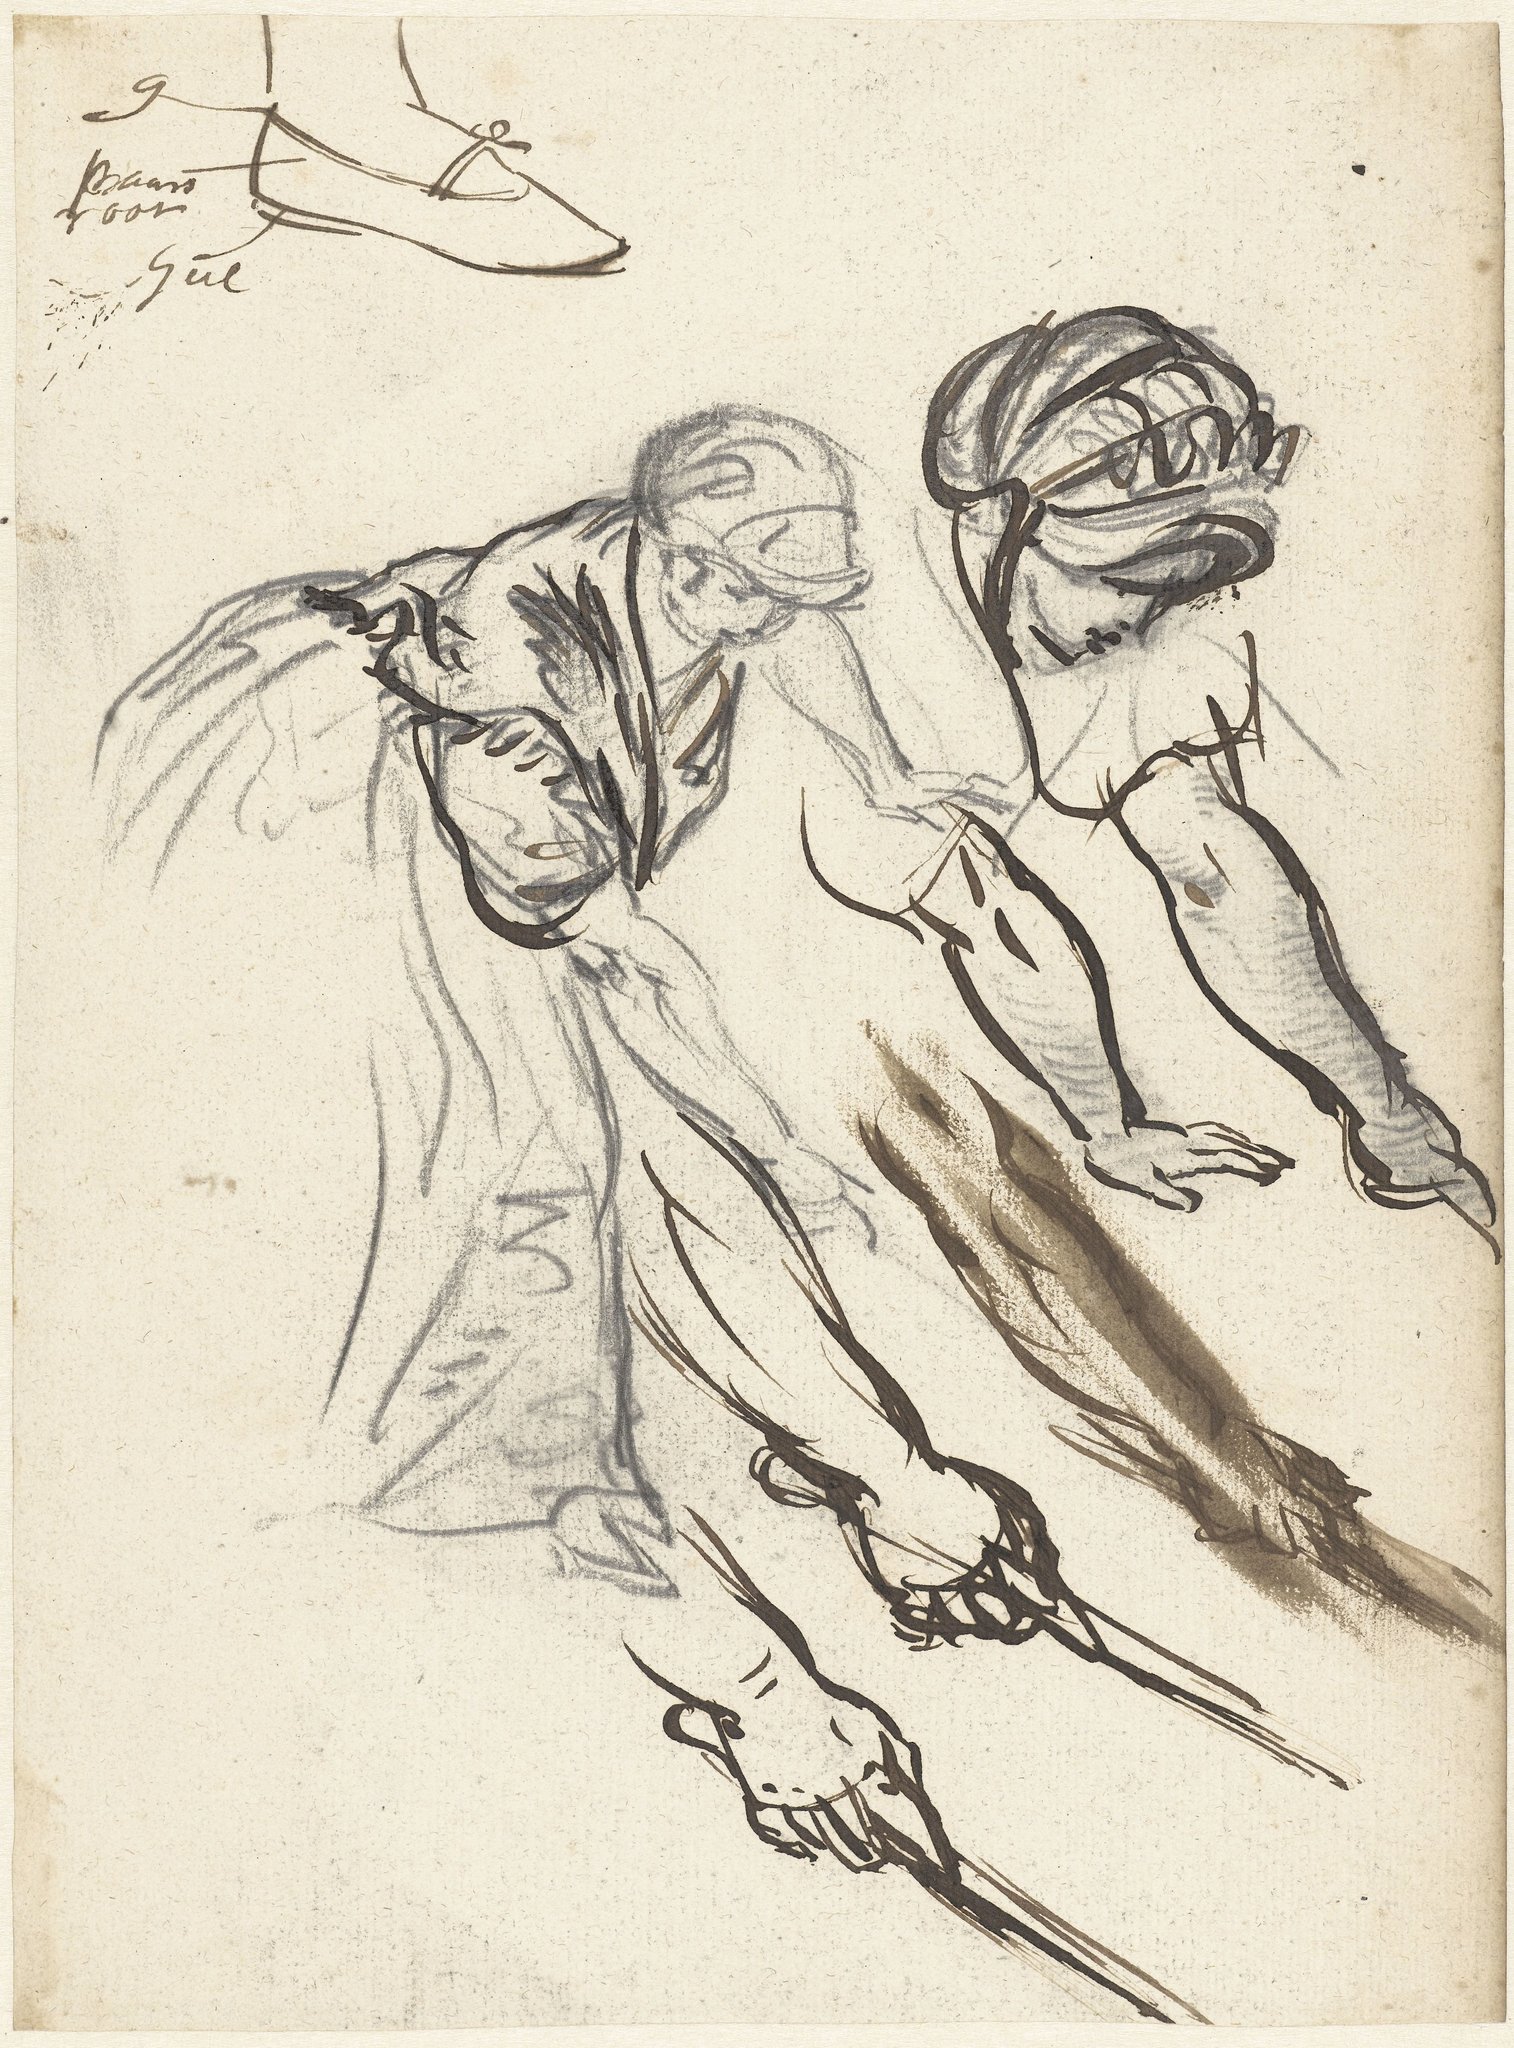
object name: drawing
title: Studies van een dienstmaagd die de kachel pookt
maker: simon andreas krausz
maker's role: draughtsman, print maker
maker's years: 1760-1825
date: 1770-1825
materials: ink, paper, pencil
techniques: pen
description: Schetsblad met studies van een dienstmaagd die de kachel pookt.